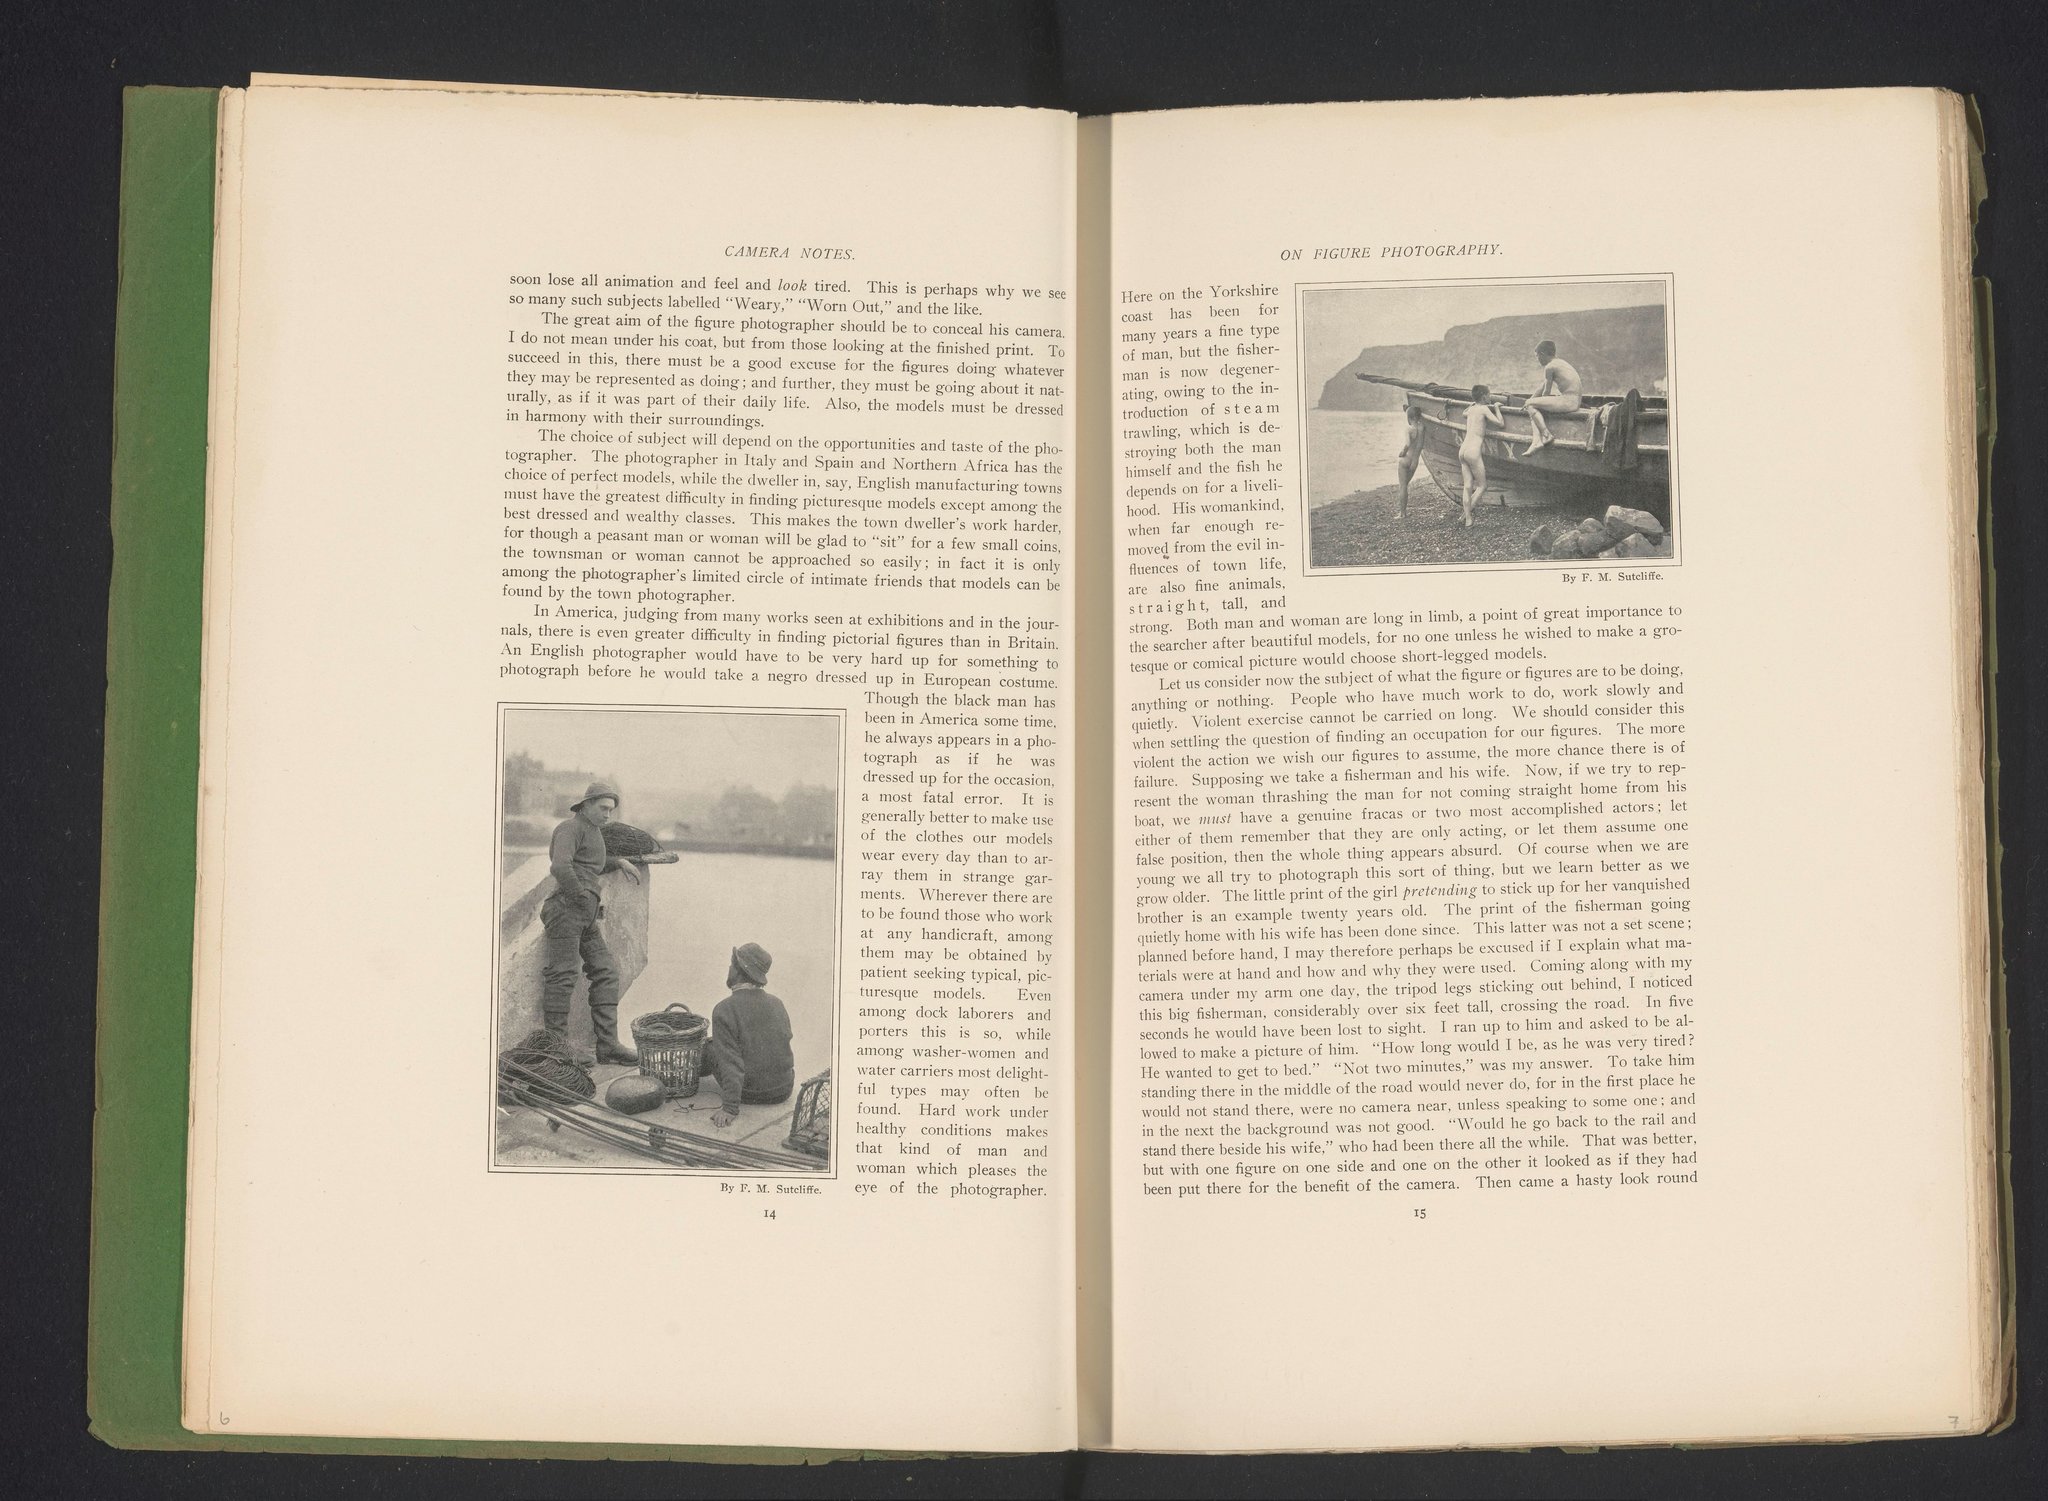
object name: photomechanical print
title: Drie naakte jongens bij een boot op het strand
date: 1896-1901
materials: paper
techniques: autotype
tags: sailing-ship, sailing-boat, boy (child between toddler and youth), beach